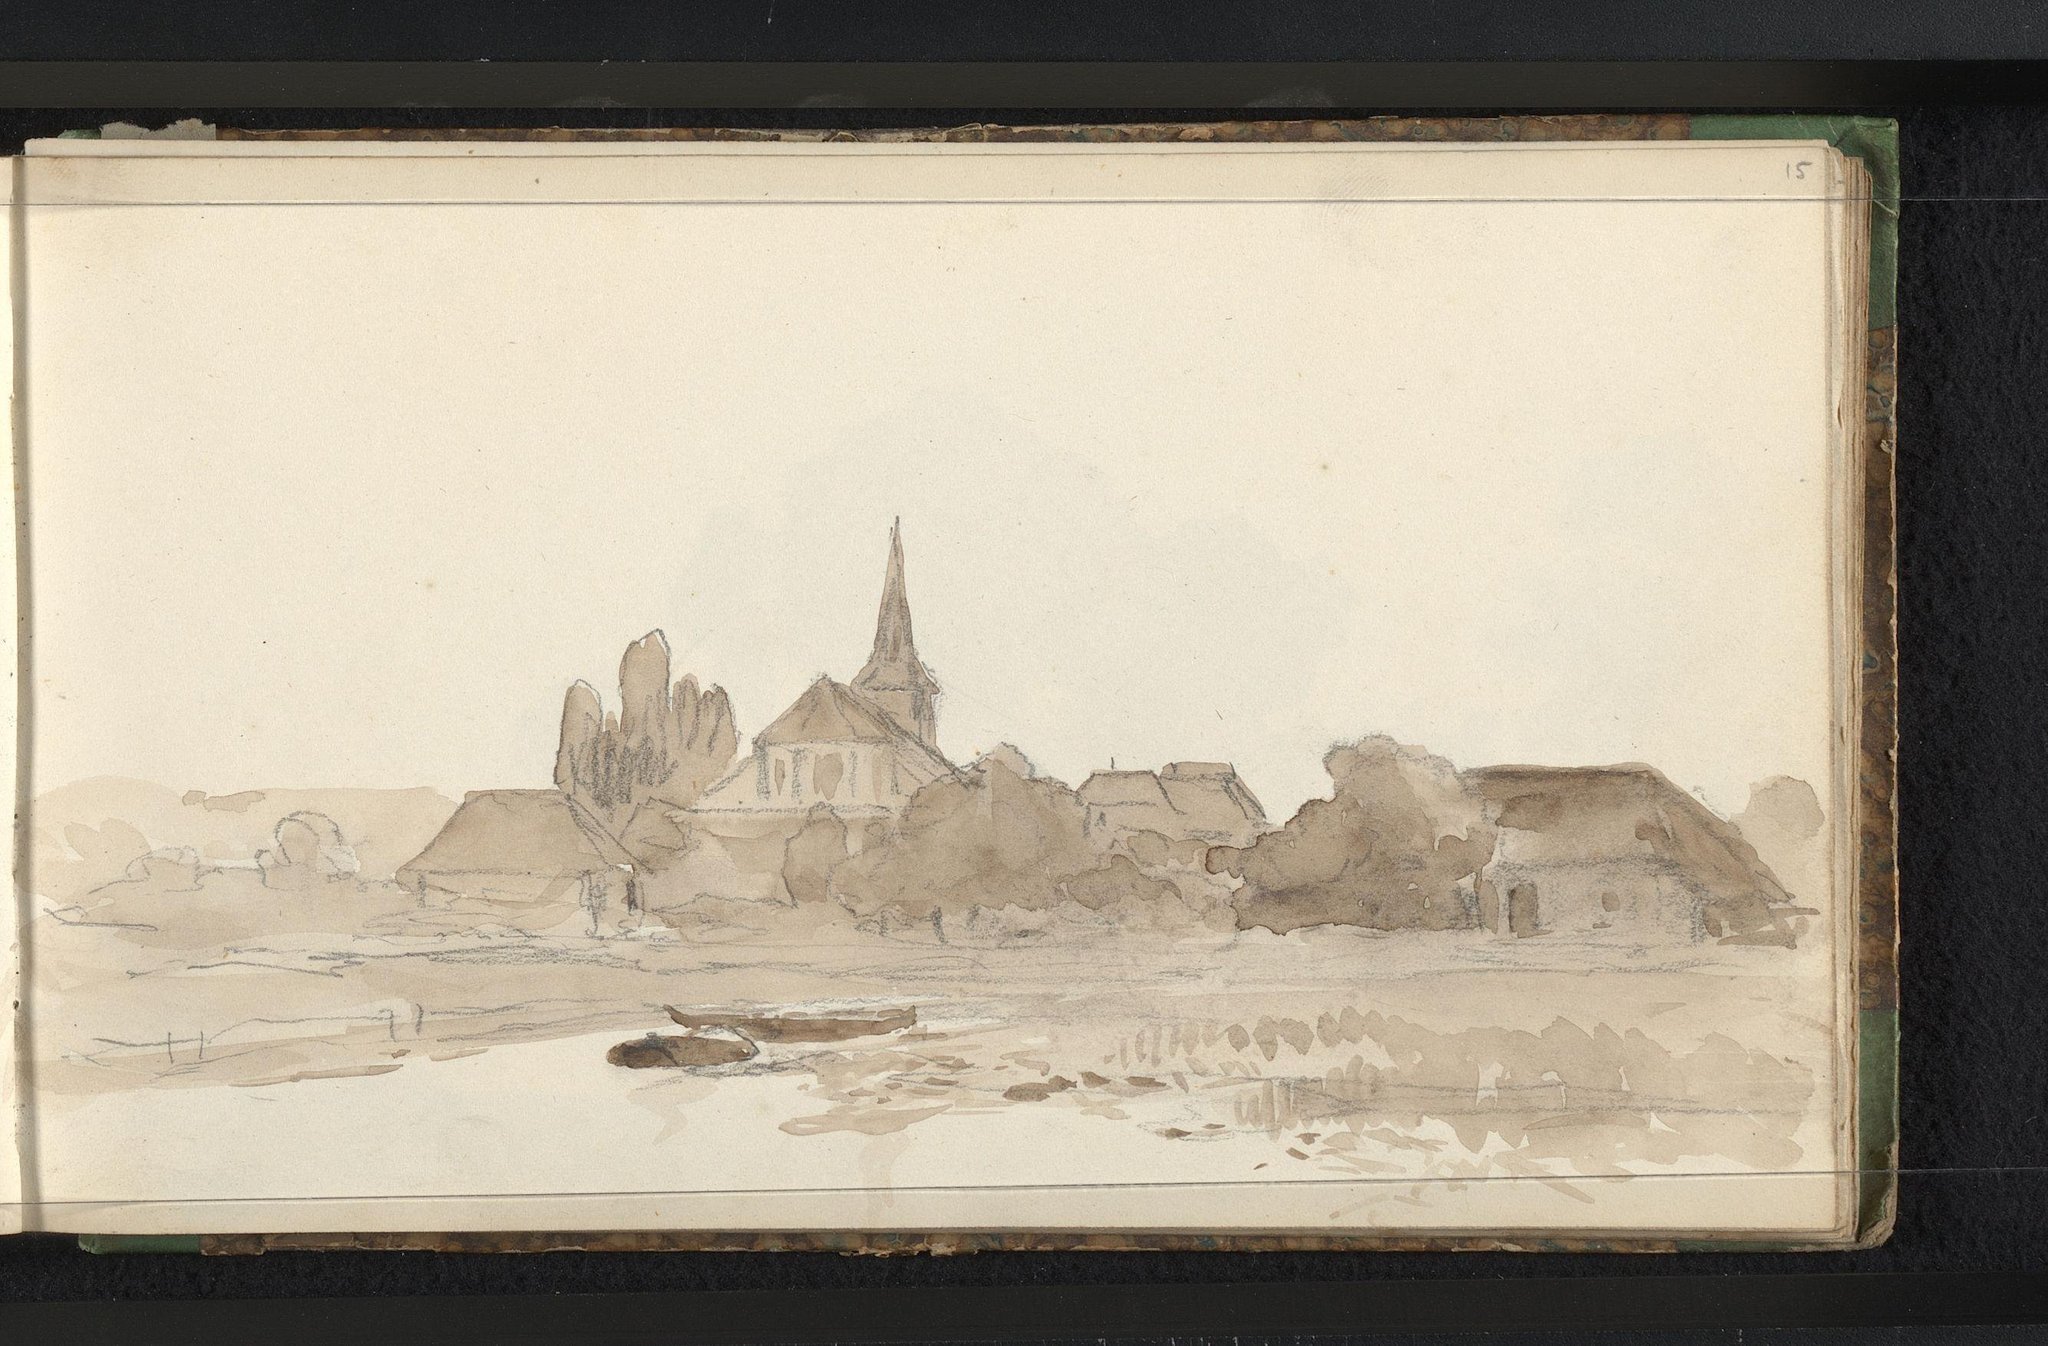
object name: sketchbook leaf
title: Landschap met water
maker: jan bedijs tom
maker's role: draughtsman, painter, print maker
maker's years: 1813-1894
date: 1828-1894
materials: paper, pencil, watercolor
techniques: brush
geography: the hague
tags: prospect of village, silhouette of village, trees, landscapes, landscapes with waters, waterscapes, seascapes (in the temperate zone), church (exterior), artist (in general) making preliminary designs, sketching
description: Pagina 15 recto uit een schetsboek met 50 bladen.